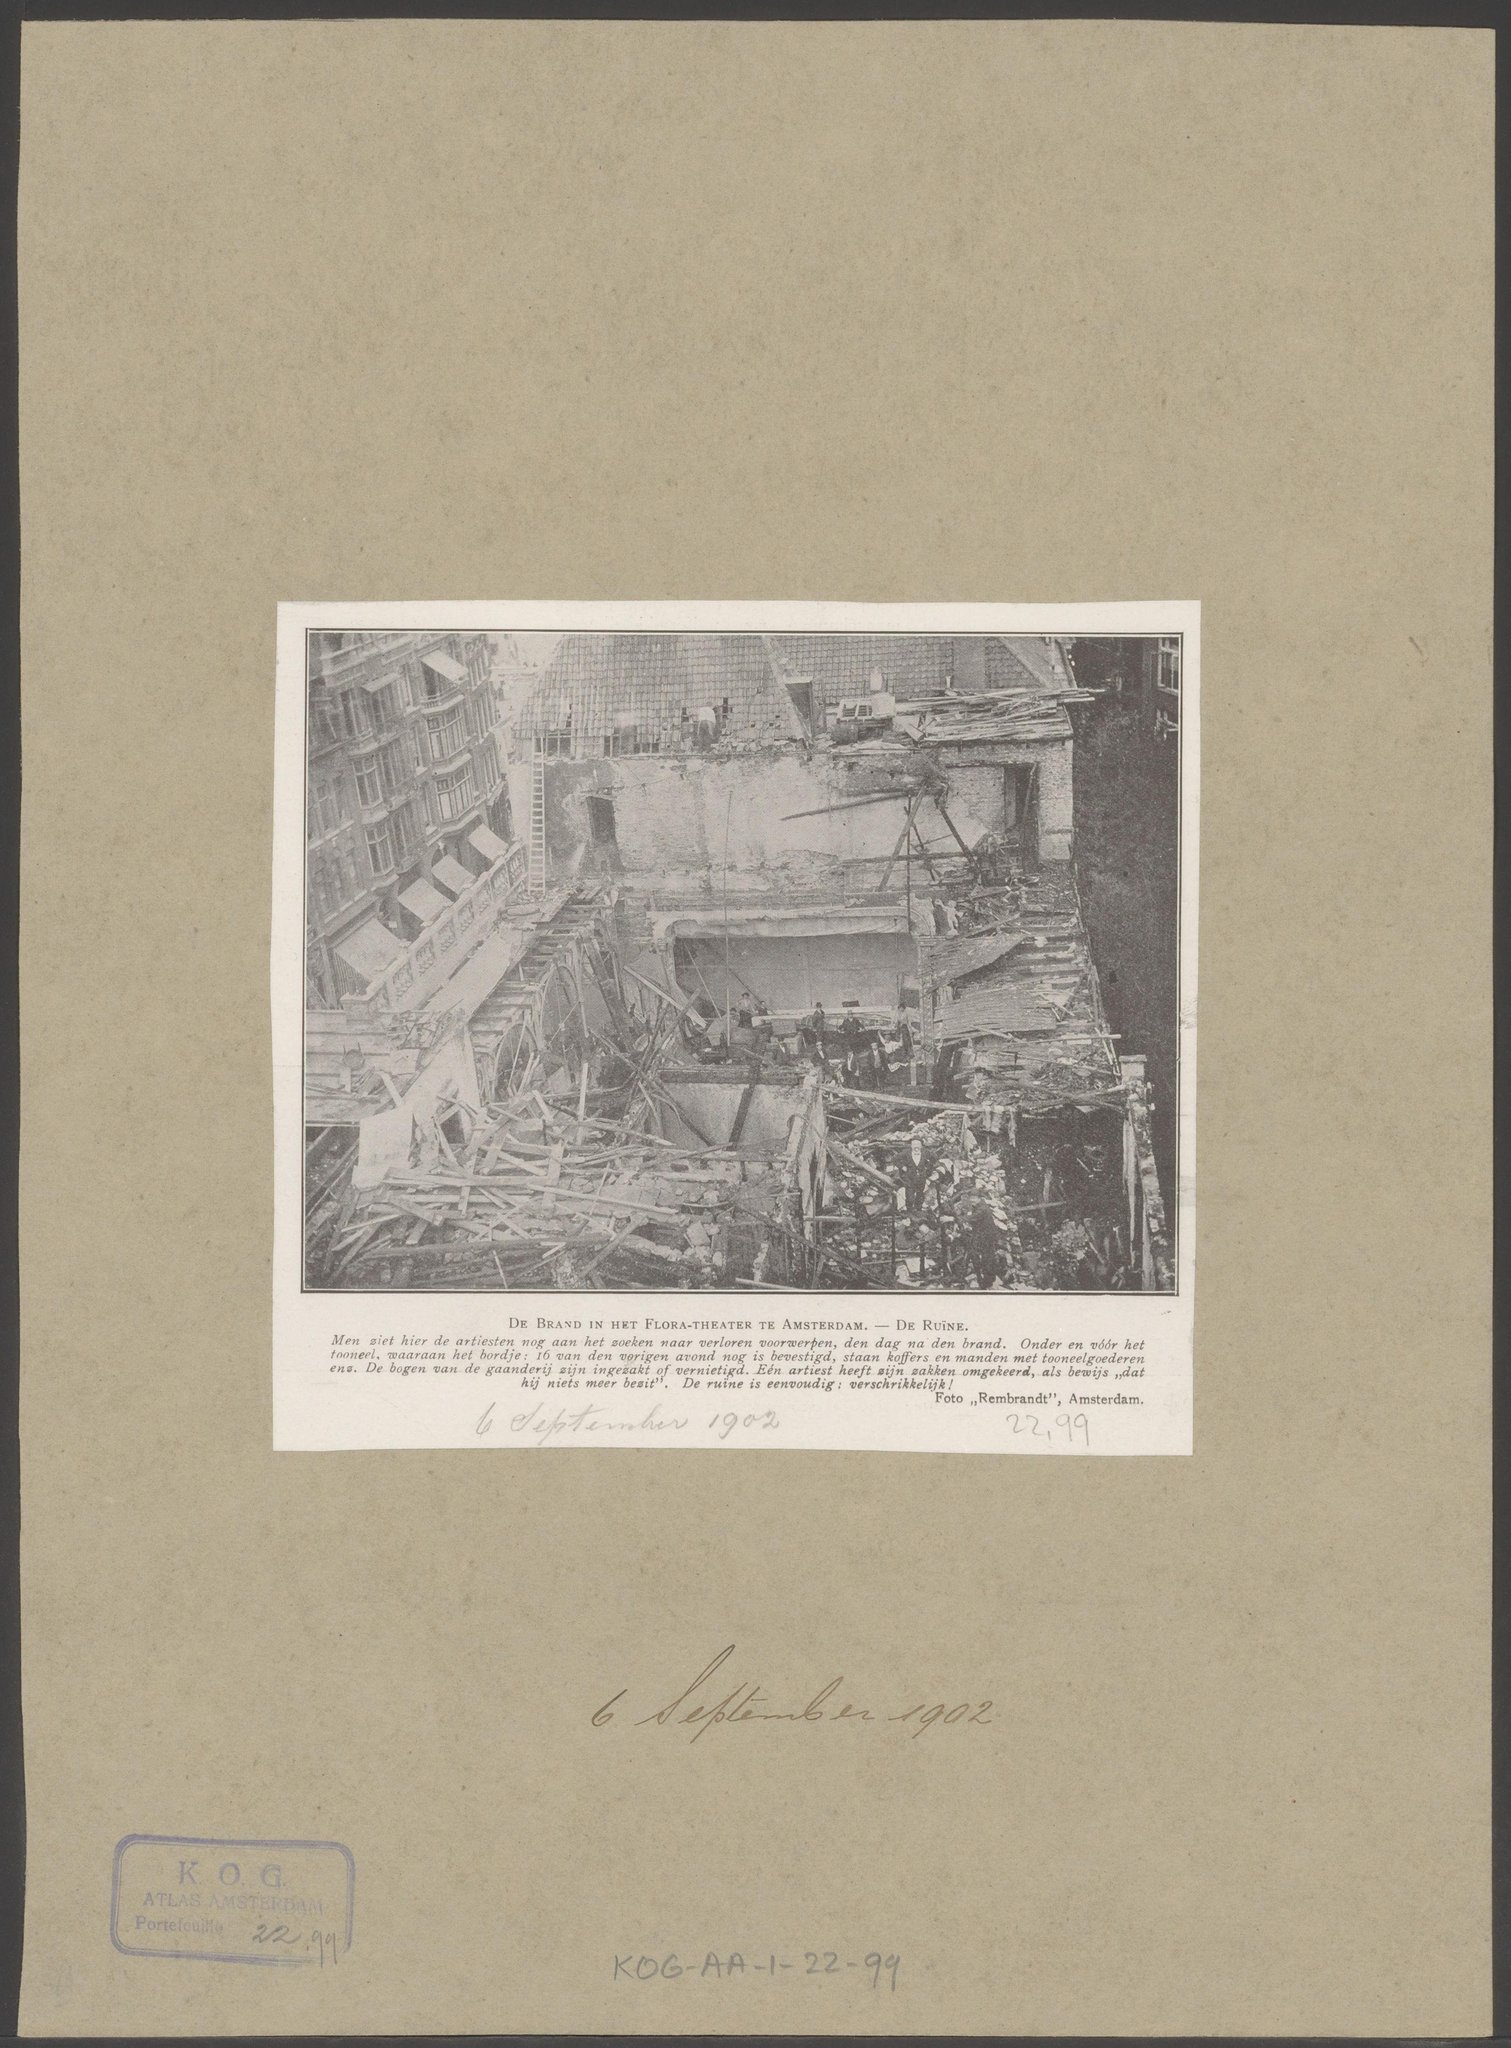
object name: photomechanical print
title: De Brand in het Flora-theater te Amsterdam - De Ruïne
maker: Anonymous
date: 1902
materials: paper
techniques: letterpress printing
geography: rotterdam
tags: ruin of a building ~ architecture, theatre (building)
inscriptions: collector's mark: Lugt 1641b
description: Onderwerpsrubriek binnen de Atlas Amsterdam: Gemeentewerken: B. Branden in particuliere gebouwen.